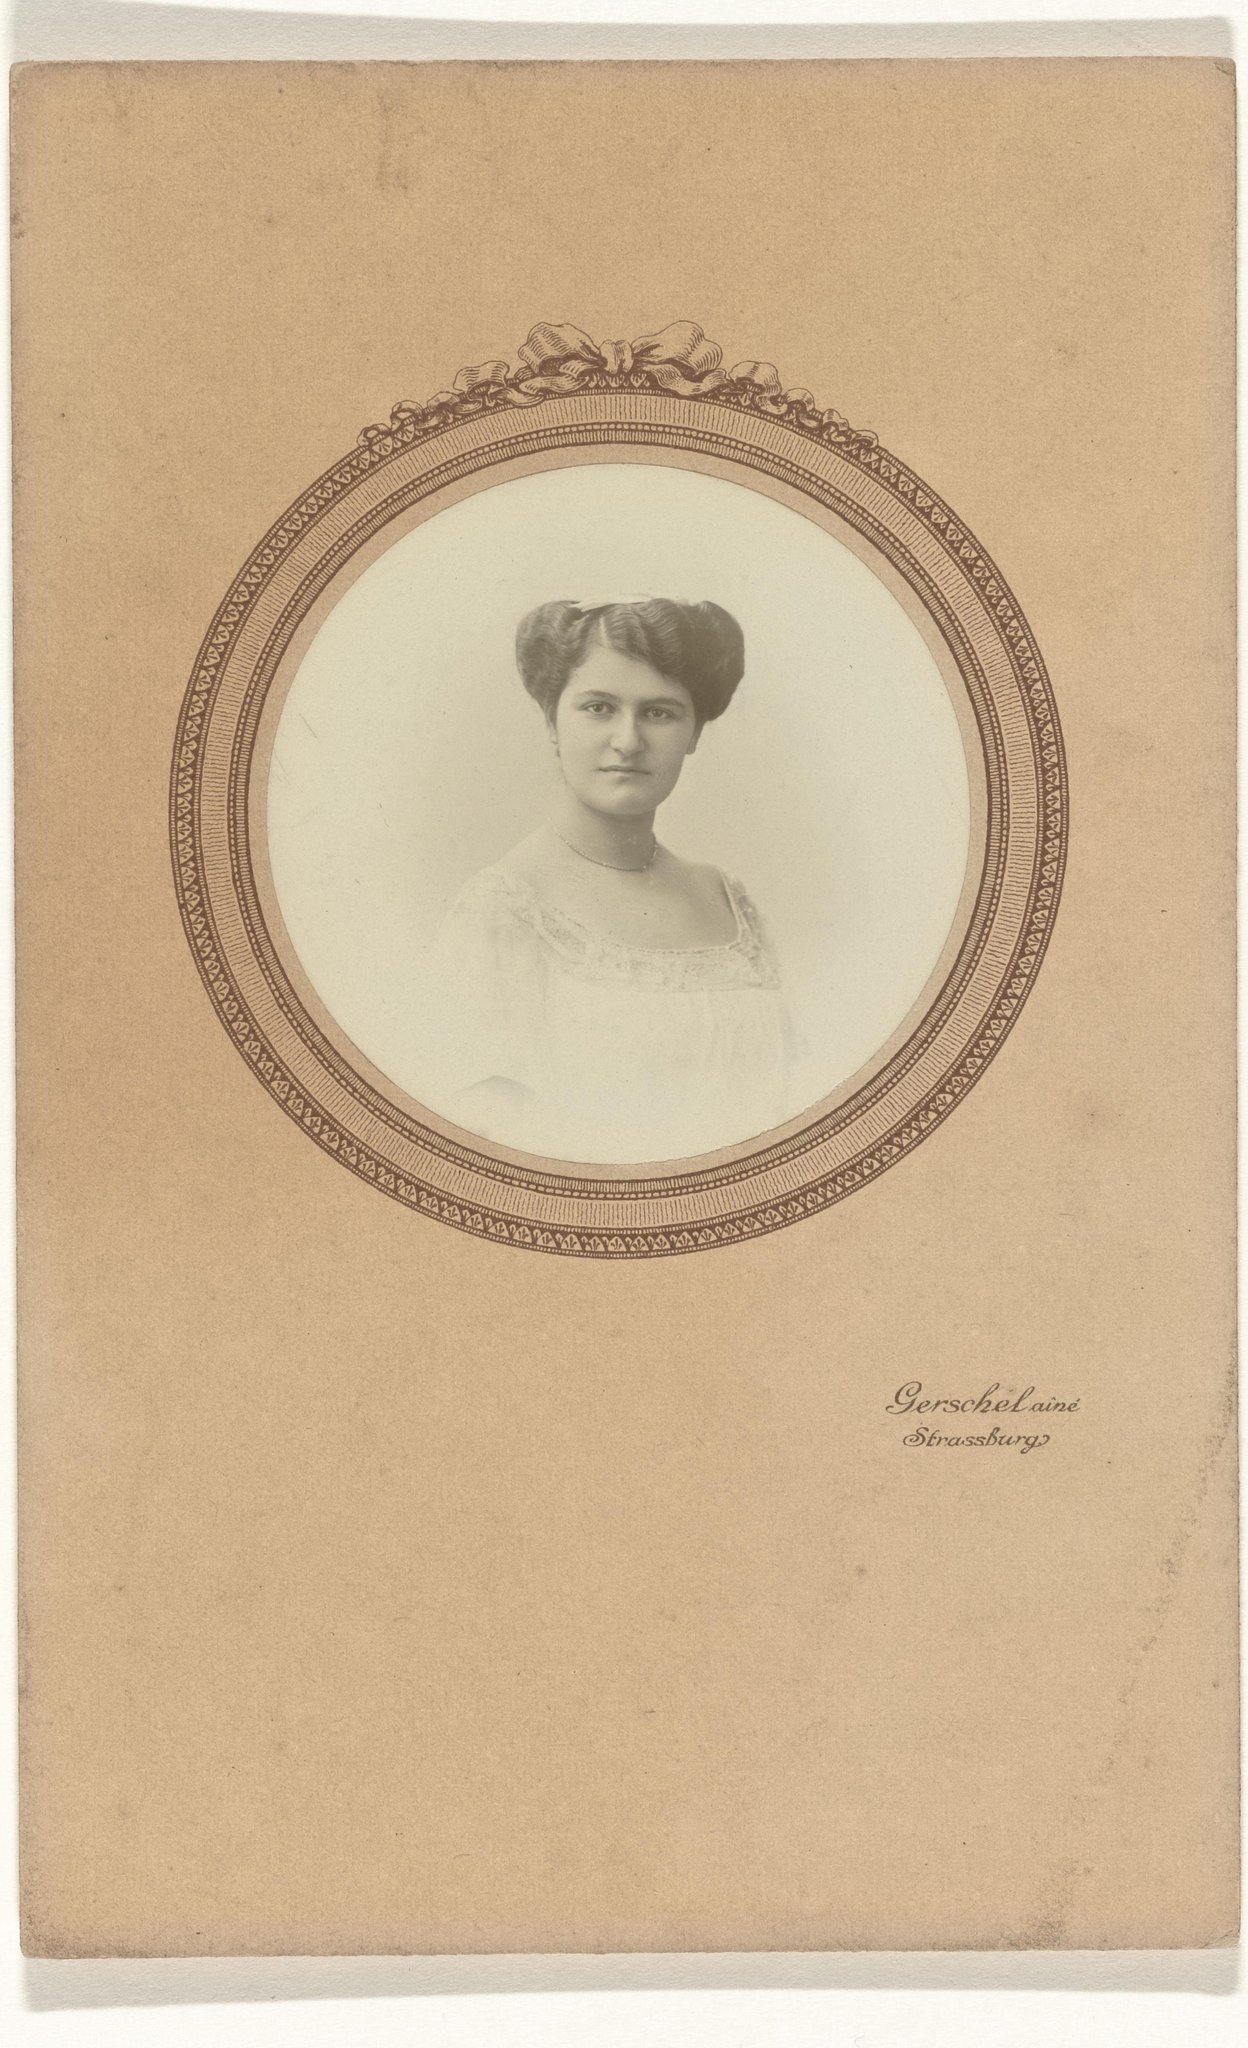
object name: photograph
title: Passepartout van Mathilde Wachenheimer-Wertheimer als jonge vrouw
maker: gerschel aîné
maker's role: fotograaf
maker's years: 1828-1898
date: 1880-1895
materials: photographic support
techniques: gelatin silver print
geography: straatsburg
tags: sobibór, mathilde wachenheimer-wertheimer, straatsburg (frankrijk)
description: Passepartout van Mathilde Wachenheimer-Wertheimer als jonge vrouw, in lichte kleding.